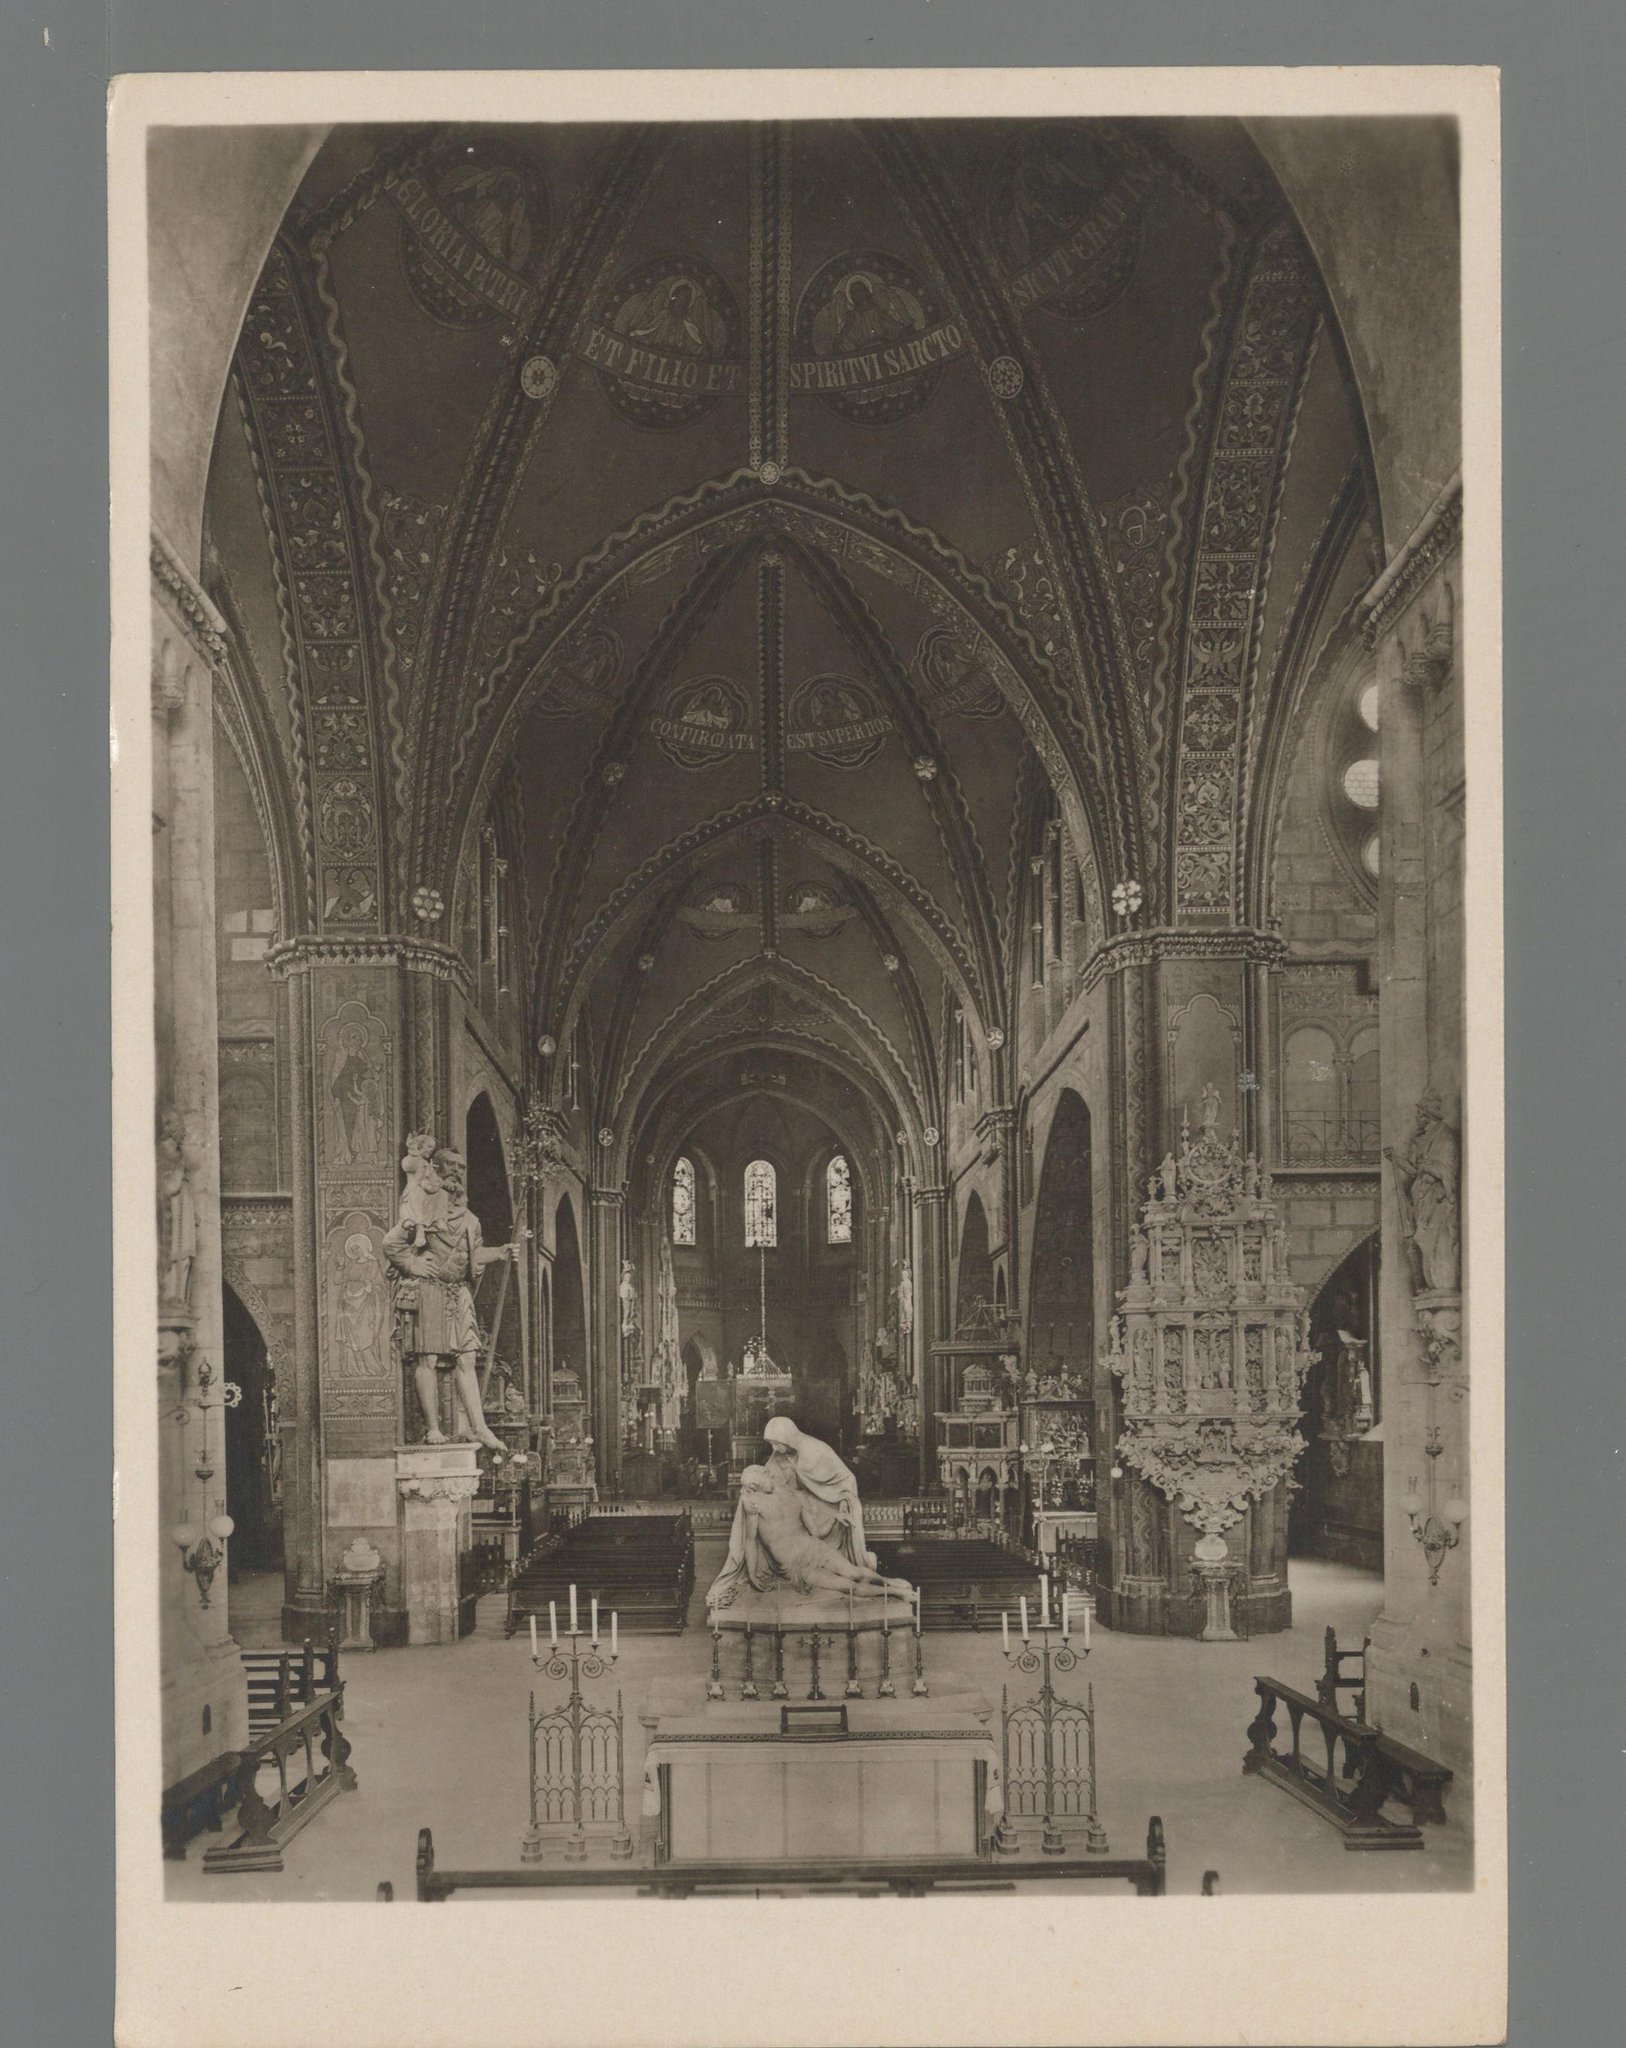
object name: photograph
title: Der Dom zu Münster i. W. Mittelschiff nach Osten, Hauptbauzeit 1225/65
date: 1905-1940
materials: photographic support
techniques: gelatin silver print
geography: berlin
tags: parts of church interior: nave, interior of church